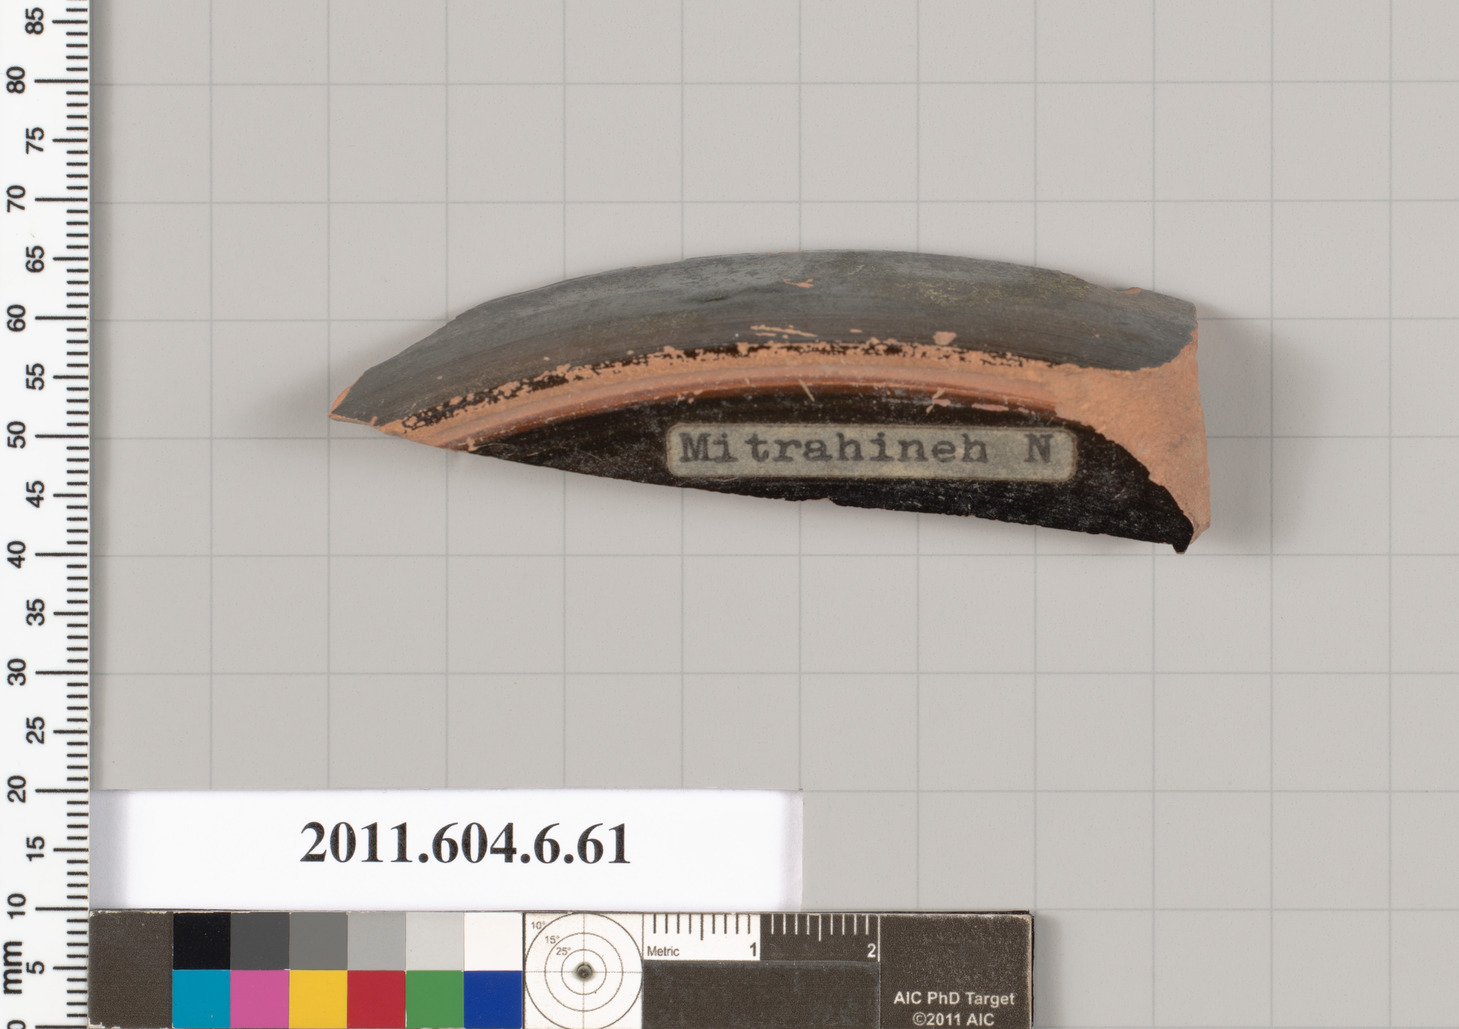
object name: stemmed plate fragment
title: Terracotta fragment of a stemmed plate?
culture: greek, attic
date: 500-401 BCE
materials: terracotta